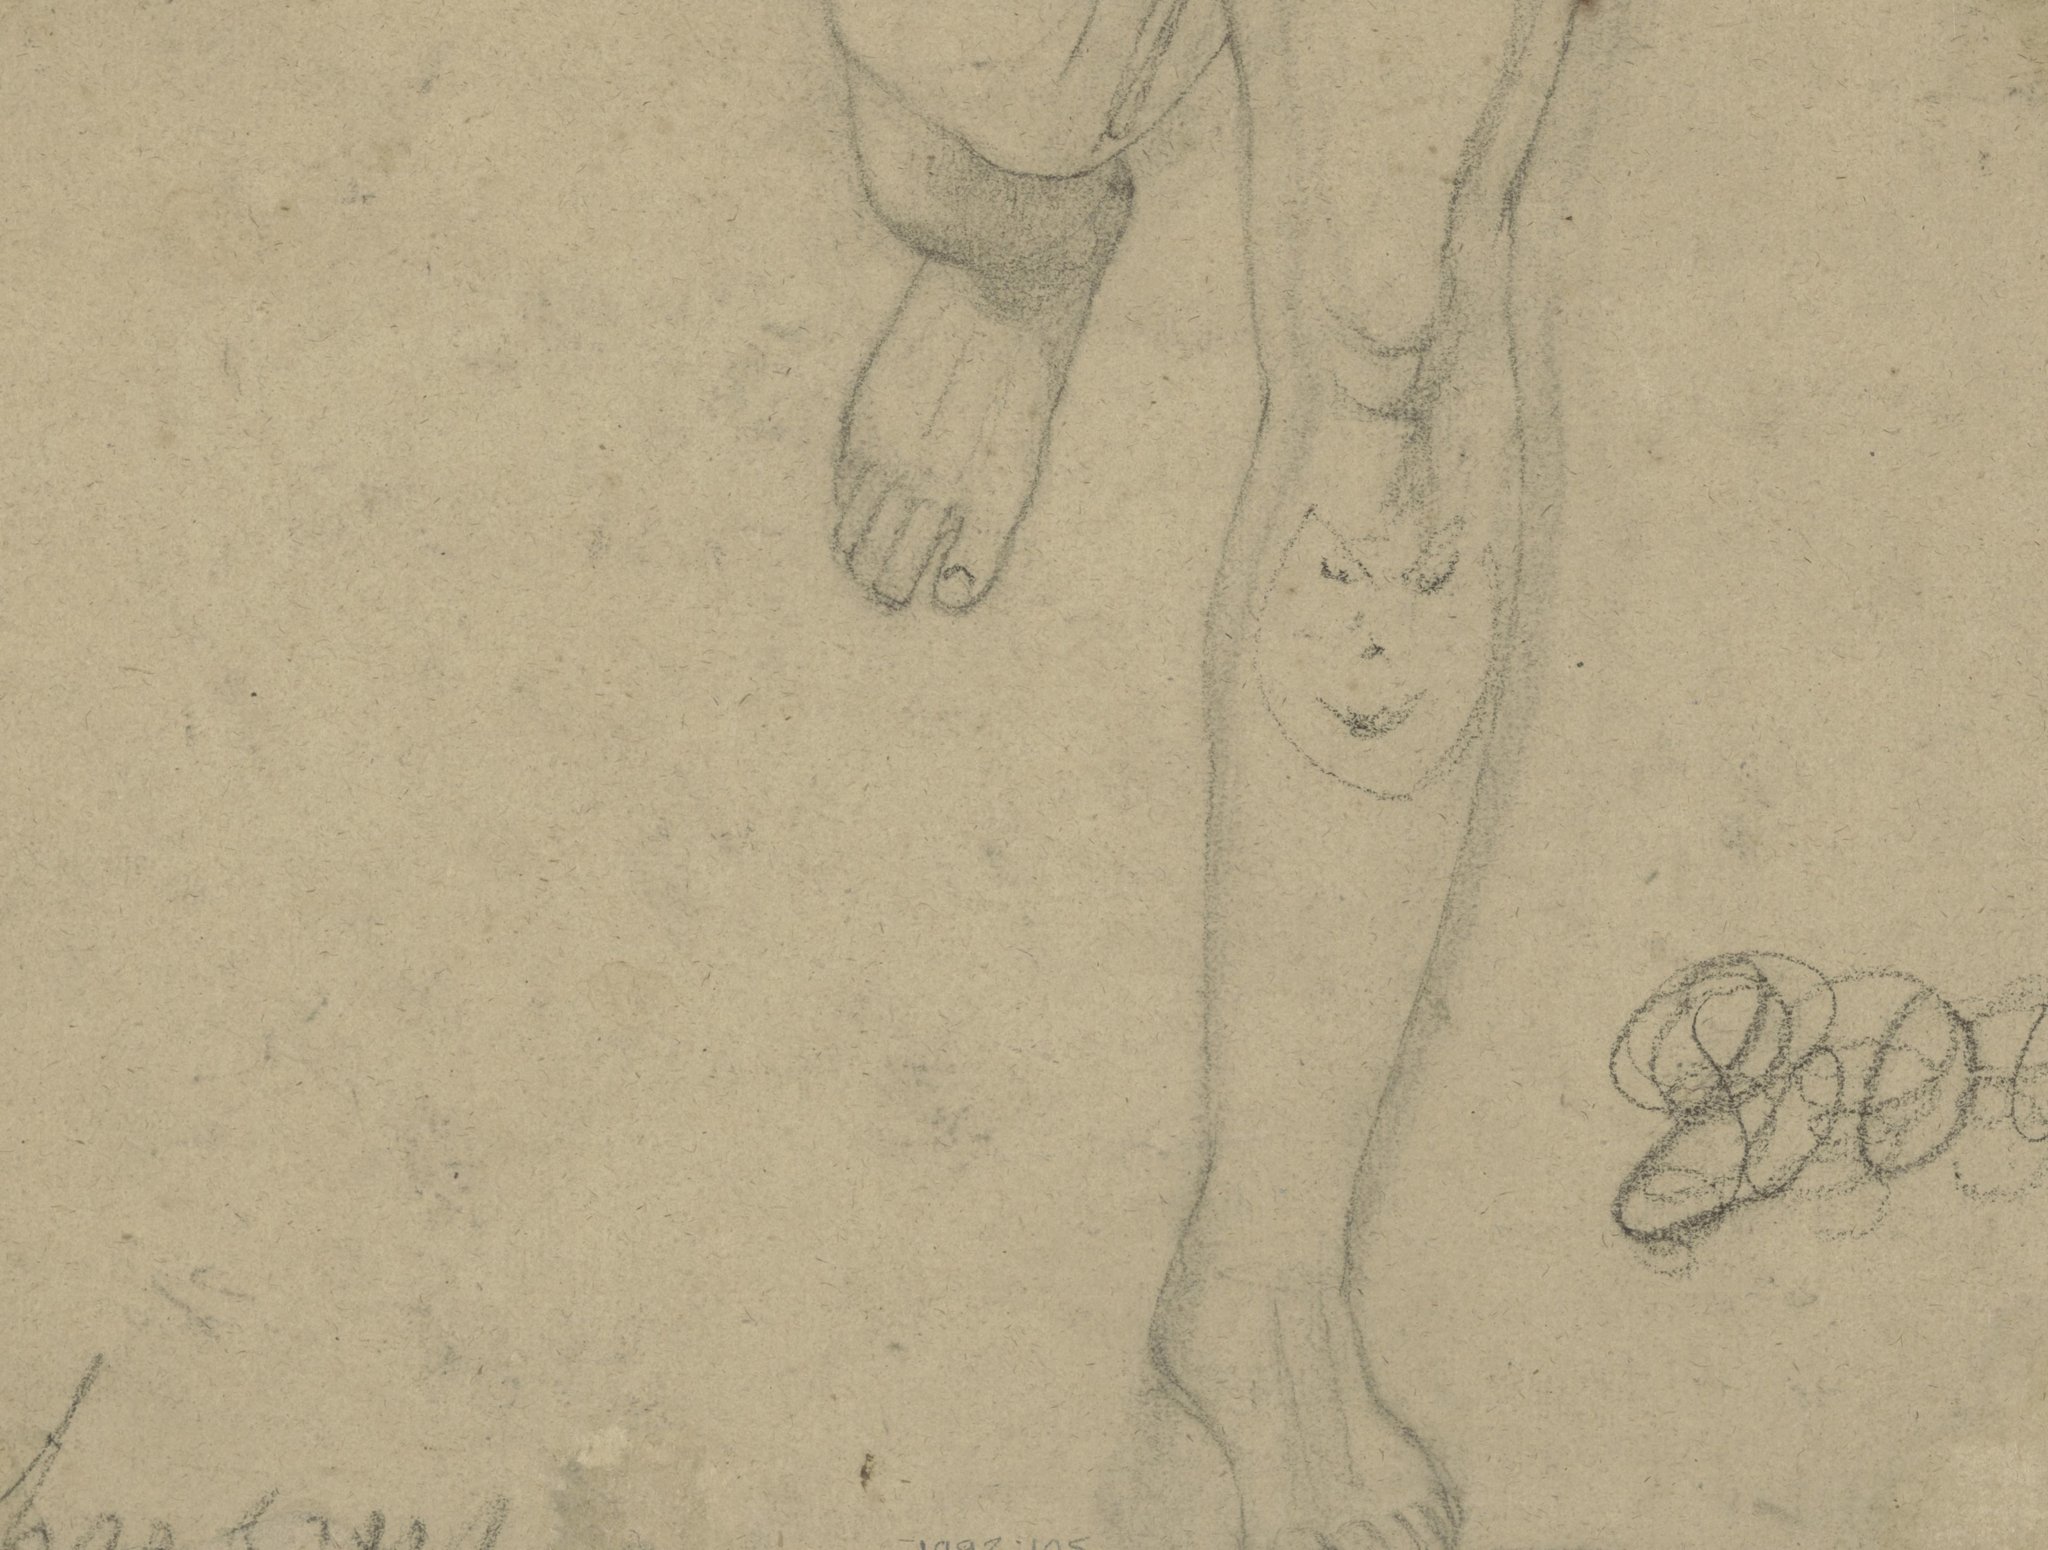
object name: drawing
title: Studie van de benen van een rennende figuur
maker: louis hersent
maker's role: painter, print maker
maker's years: 1777-1860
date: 1787-1860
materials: chalk, paper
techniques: brush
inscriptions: signature: ‘hersent’